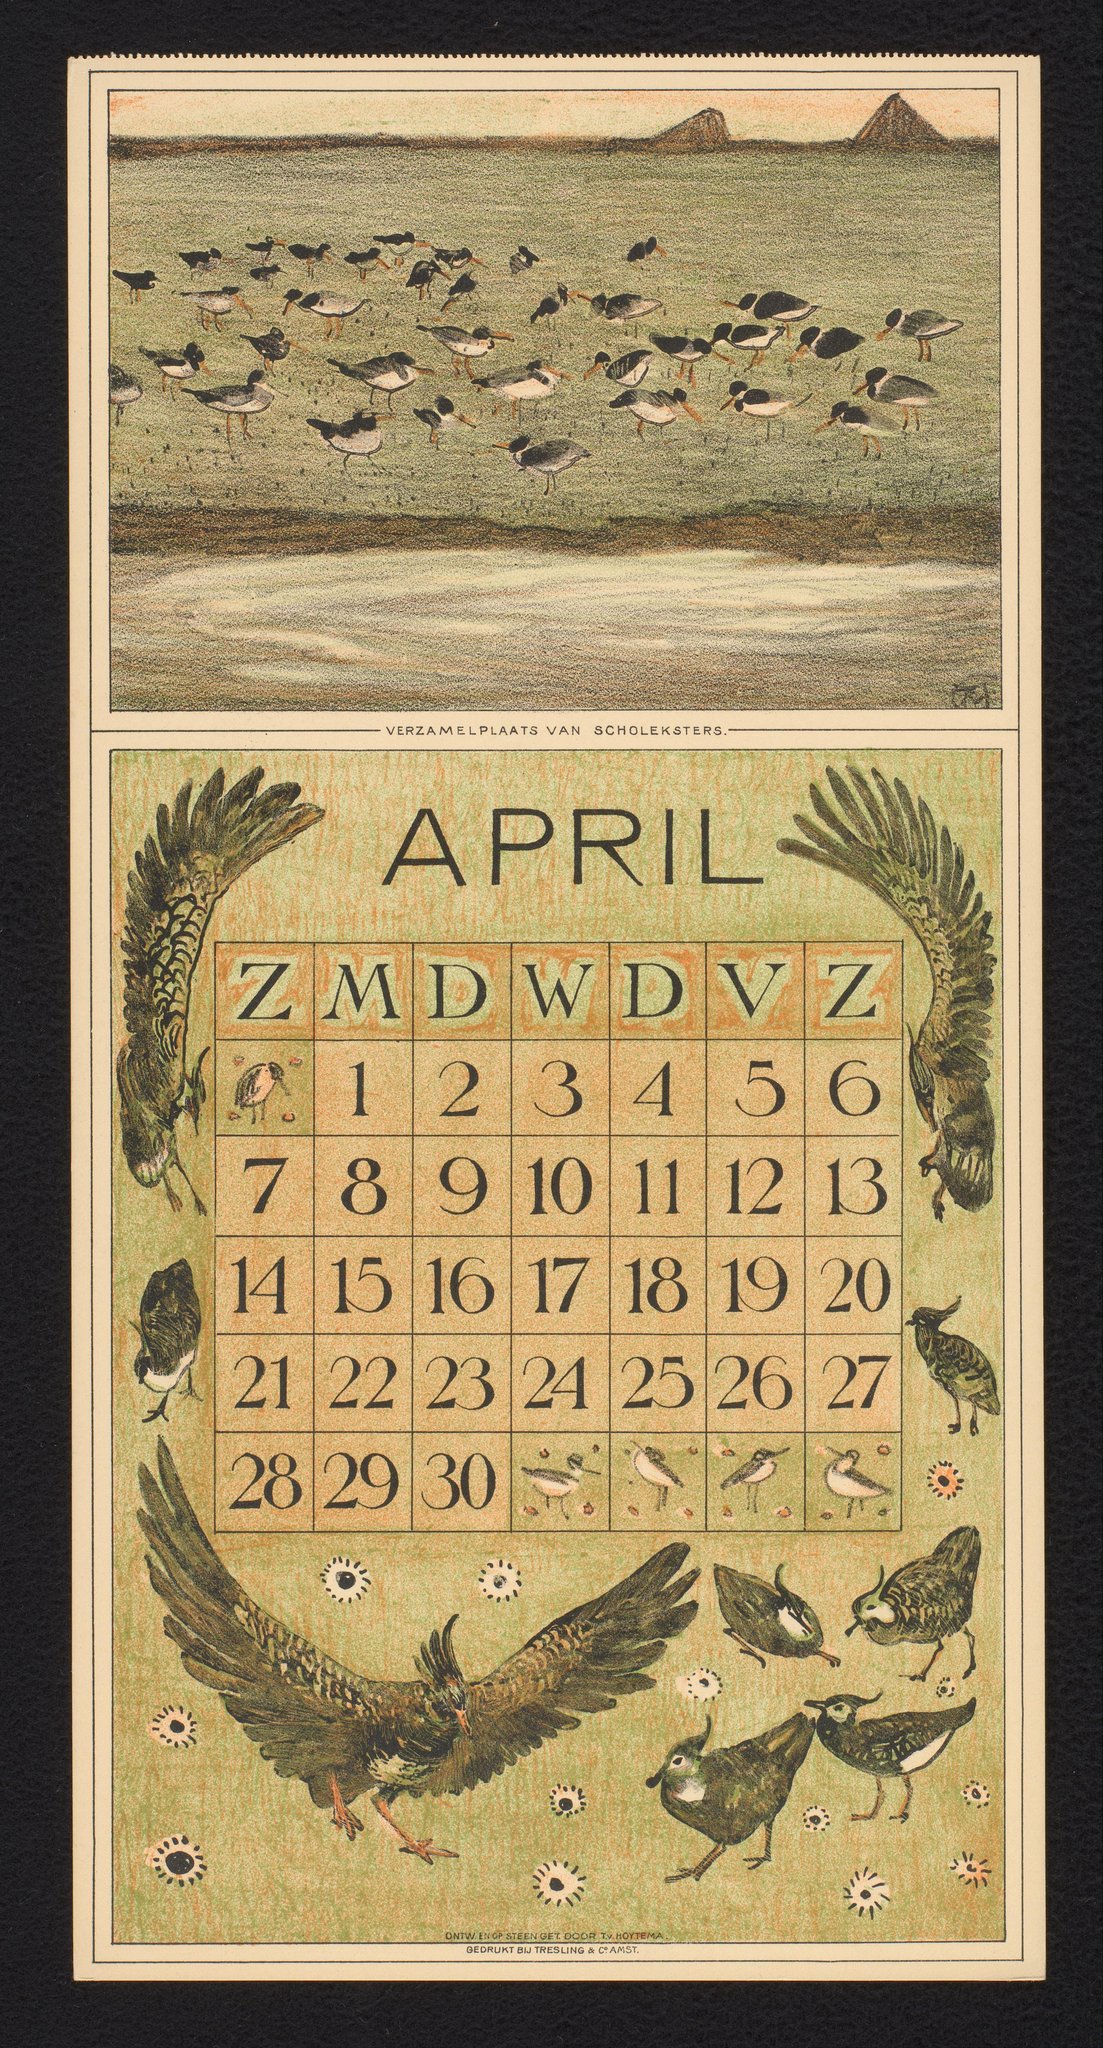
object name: calendar leaf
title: Kalenderblad voor april 1912 met scholeksters en kieviten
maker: theo van hoytema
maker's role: draughtsman, painter, print maker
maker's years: 1863-1917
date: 1911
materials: paper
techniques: lithograph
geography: amsterdam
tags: shore-birds and wading-birds: lapwing, shore-birds and wading-birds